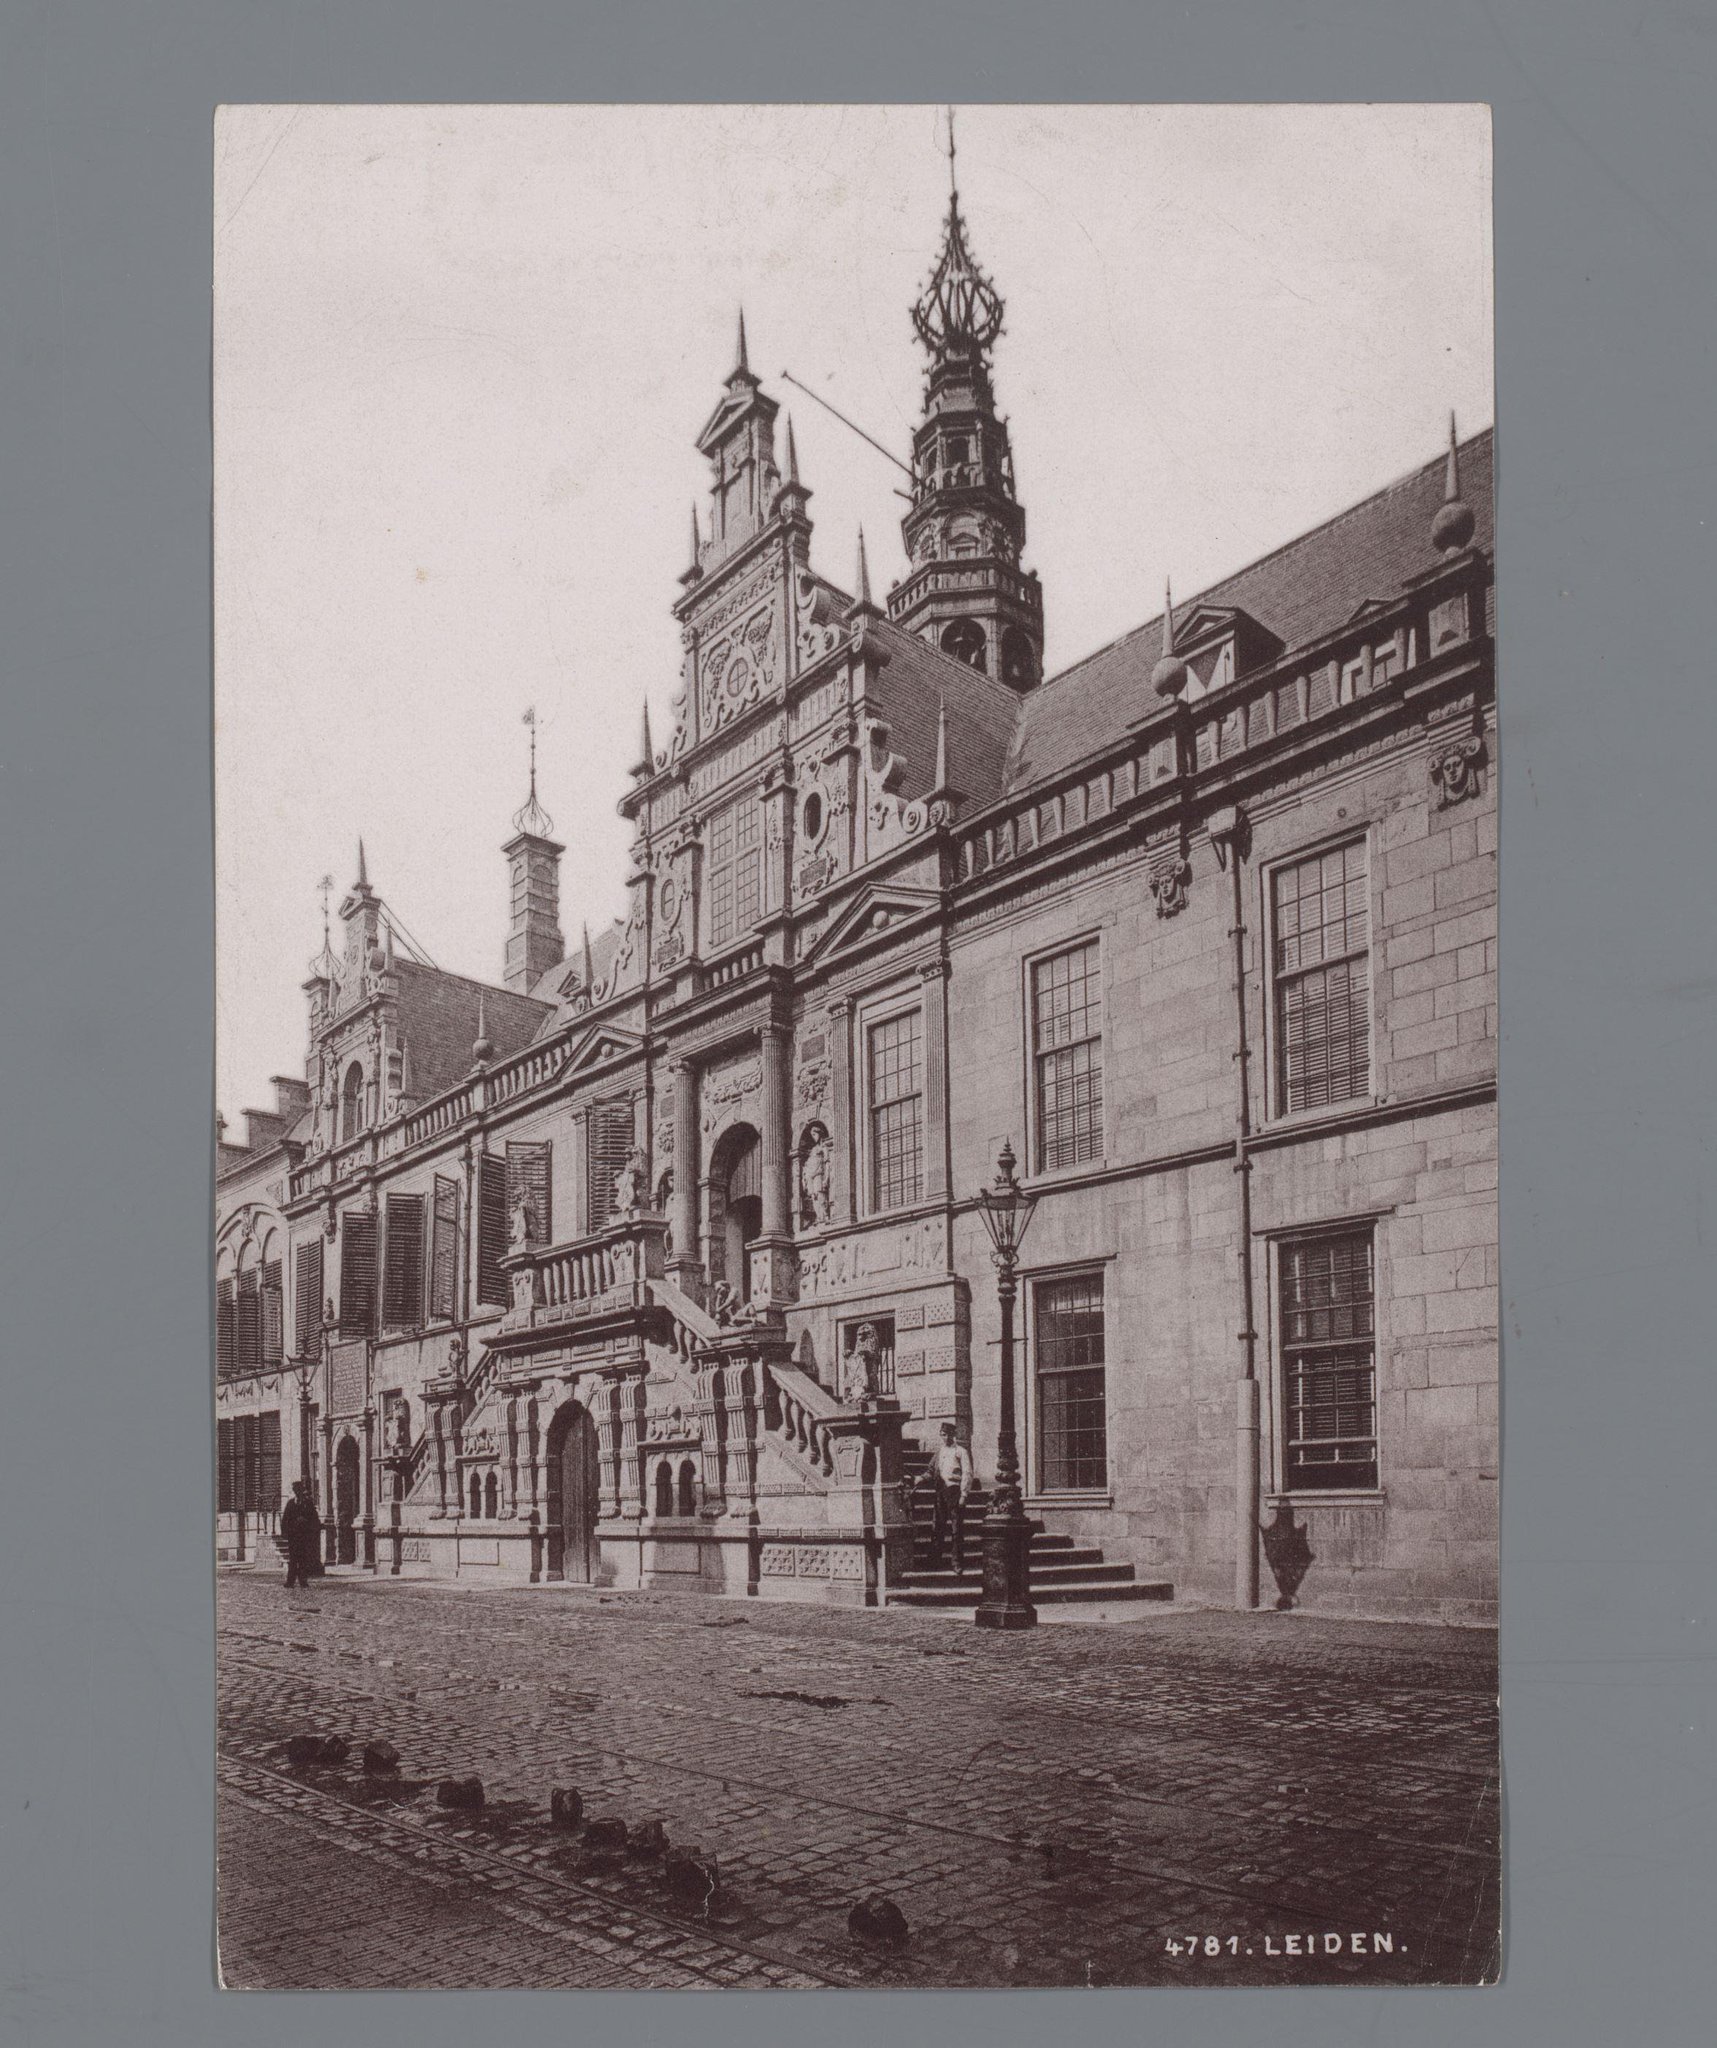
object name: photomechanical print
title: Gezicht op het stadhuis te Leiden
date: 1880-1910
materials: paper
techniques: photograph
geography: dresden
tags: townhall, leiden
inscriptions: inscription: ‘4781. Leiden.’